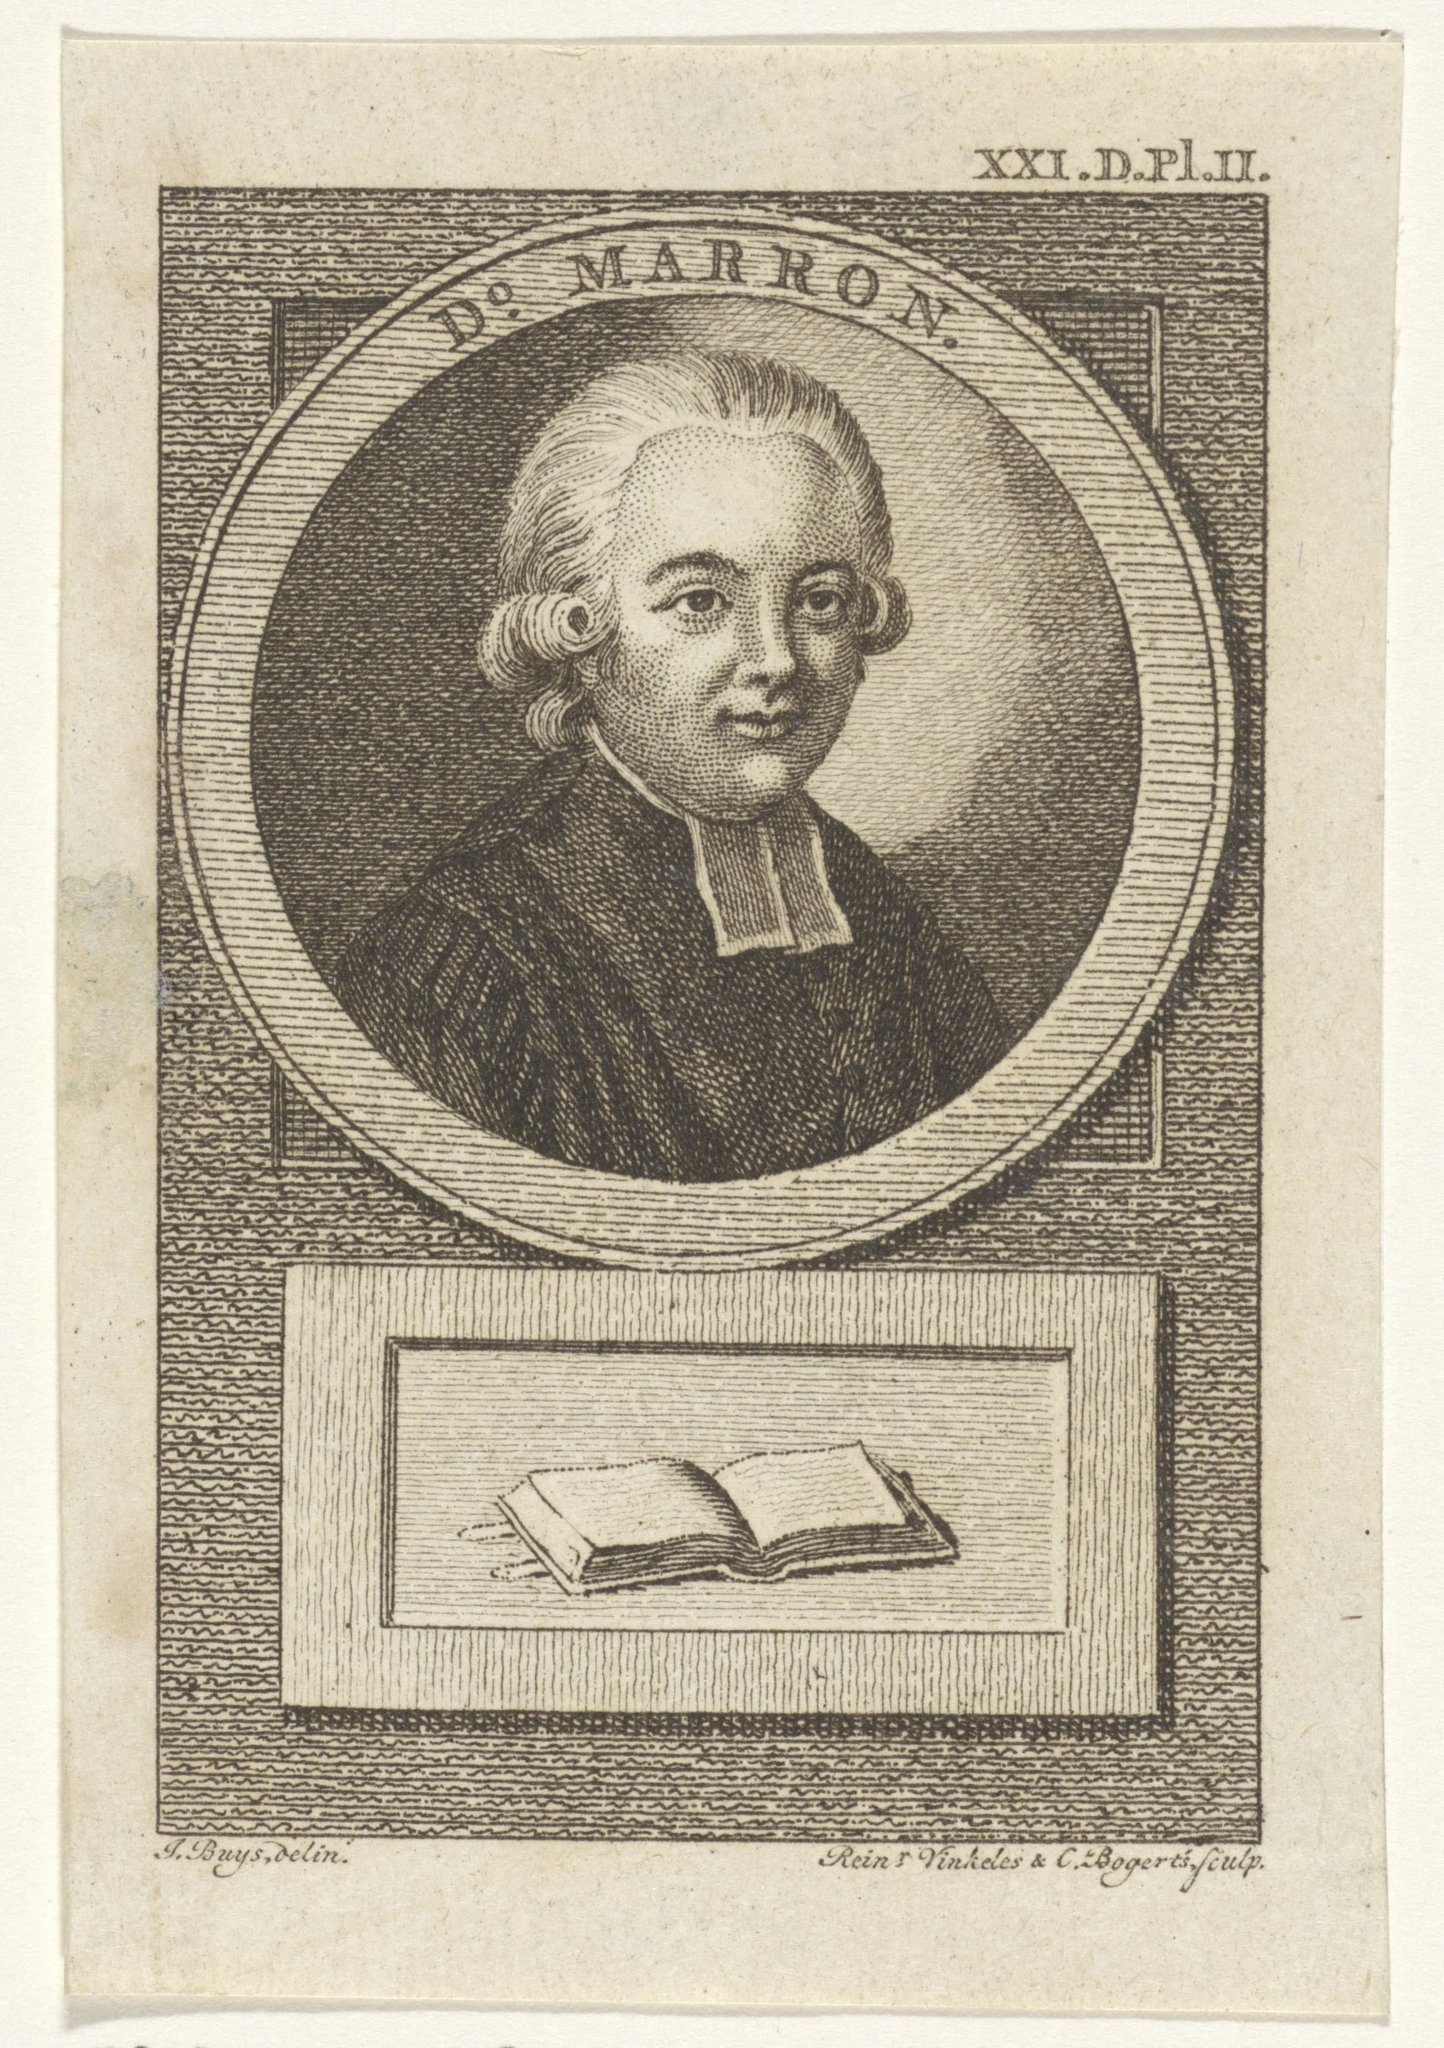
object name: print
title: Portret van Paul Henri Marron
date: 1783-1795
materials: paper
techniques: engraving, etching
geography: amsterdam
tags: leiden, paris, paul henri marron, the bible as a book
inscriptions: collector's mark: Lugt 2228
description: Prent gebruikt in: Fokke, Jan. Geschiedenissen der Vereenigde Nederlanden voor de vaderlandsche jeugd Ie-XXVste deel. Amsterdam: Johannes Allart, 1783-1795. Deel XXI.